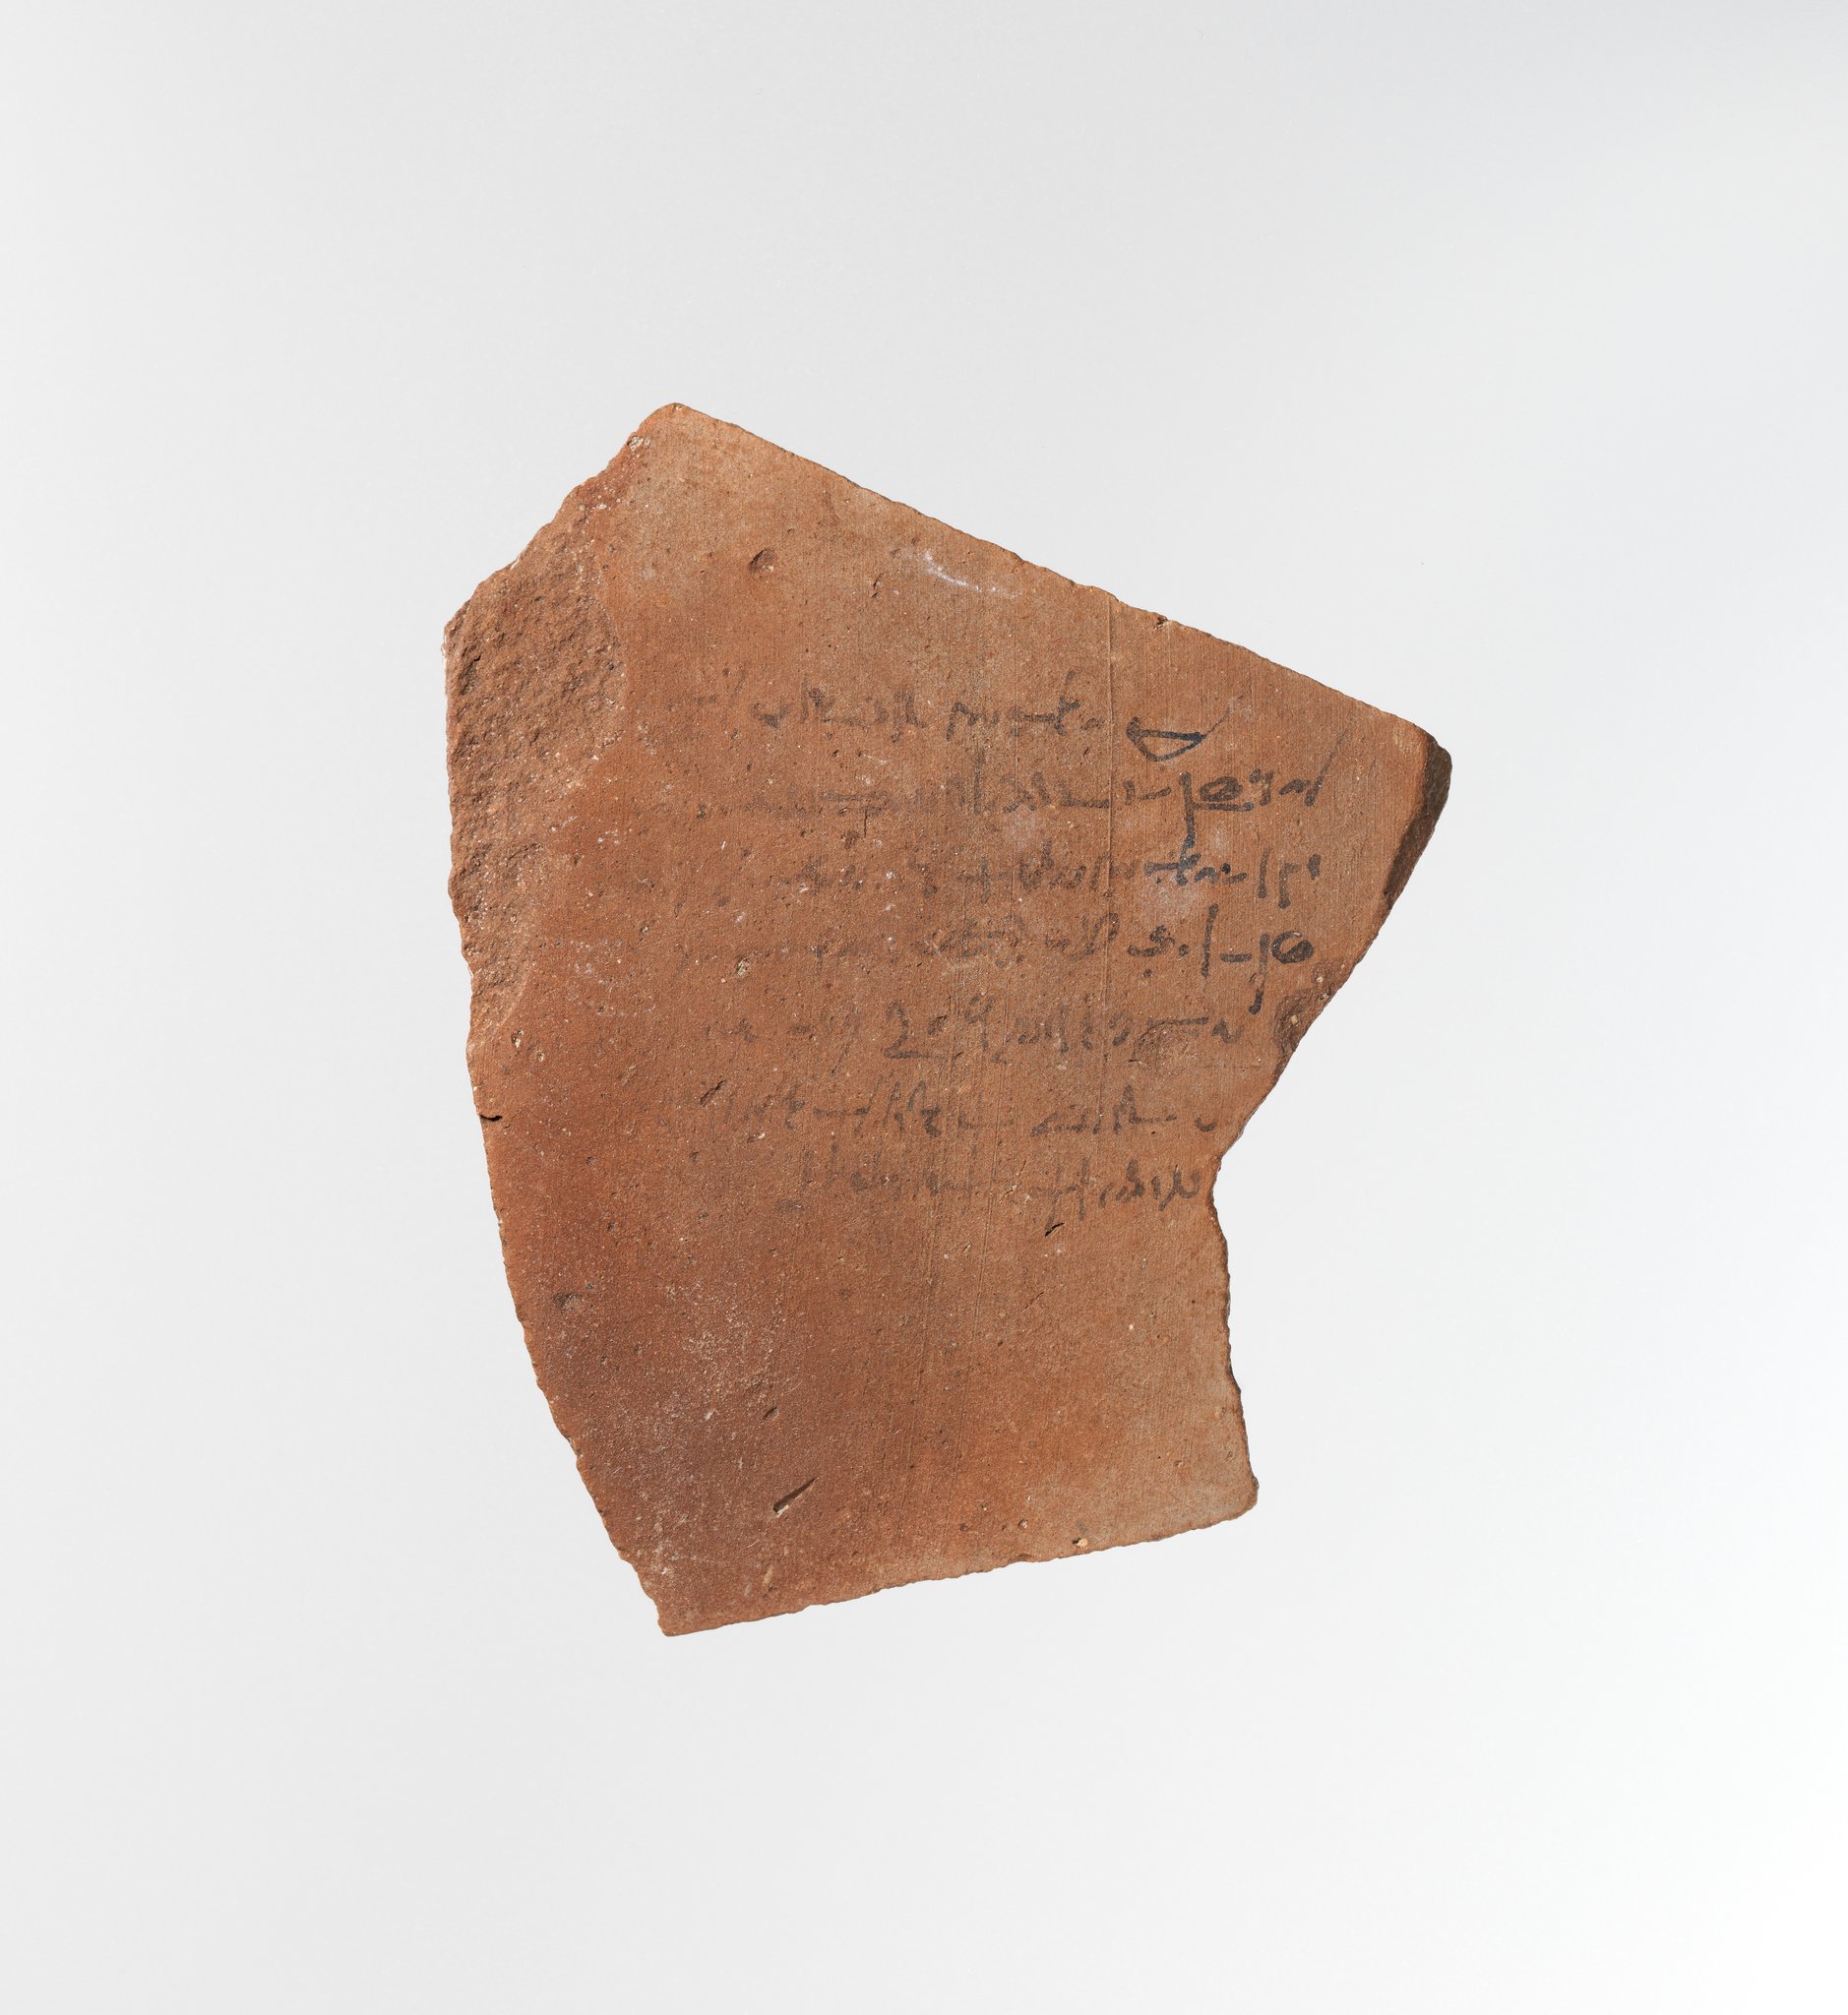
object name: ostracon, tax receipt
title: Ostracon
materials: ink, pottery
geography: egypt